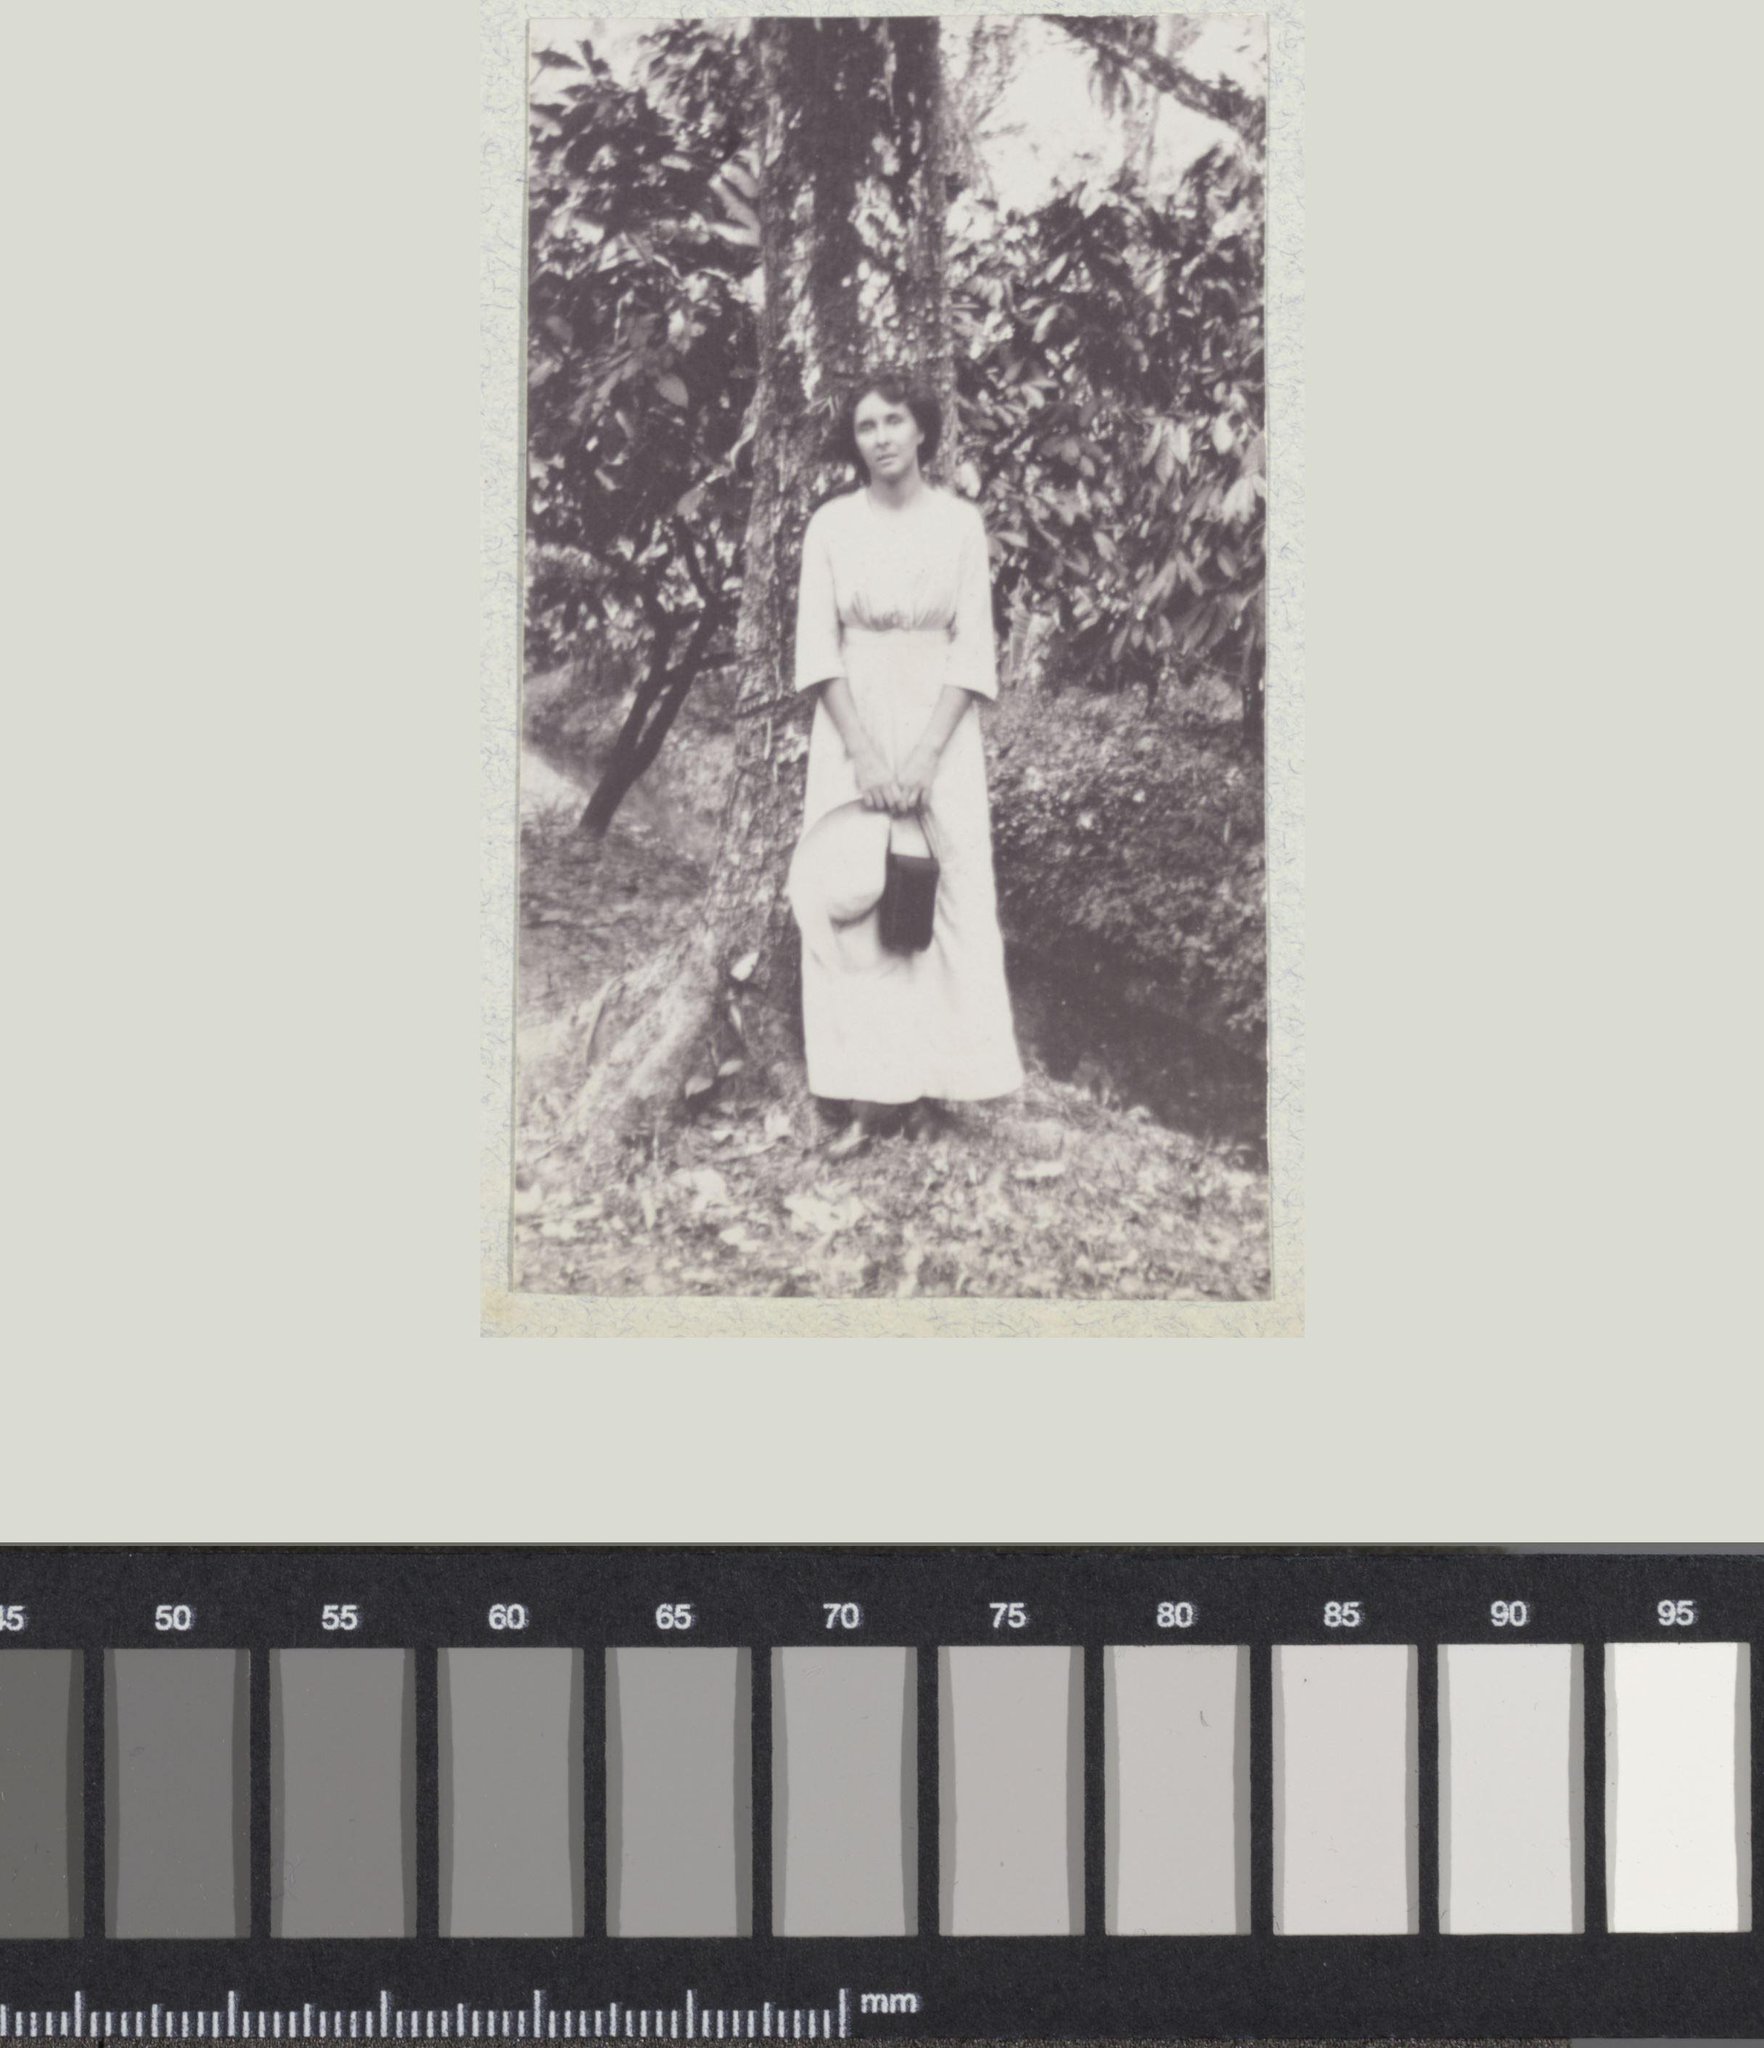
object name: photograph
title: Maria Gonggrijp staand met hoed en camera in de hand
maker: andries augustus boom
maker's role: amateurfotograaf, handelaar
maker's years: 1878-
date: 1911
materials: photographic support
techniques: photography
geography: suriname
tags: suriname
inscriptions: inscription: ‘Clevia 1911’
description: Maria Gonggrijp staand met de hoed in de hand, geleund tegen een boom, 1911. Onderdeel van het fotoalbum van de familie Boom-Gonggrijp in Suriname en Curaçao.